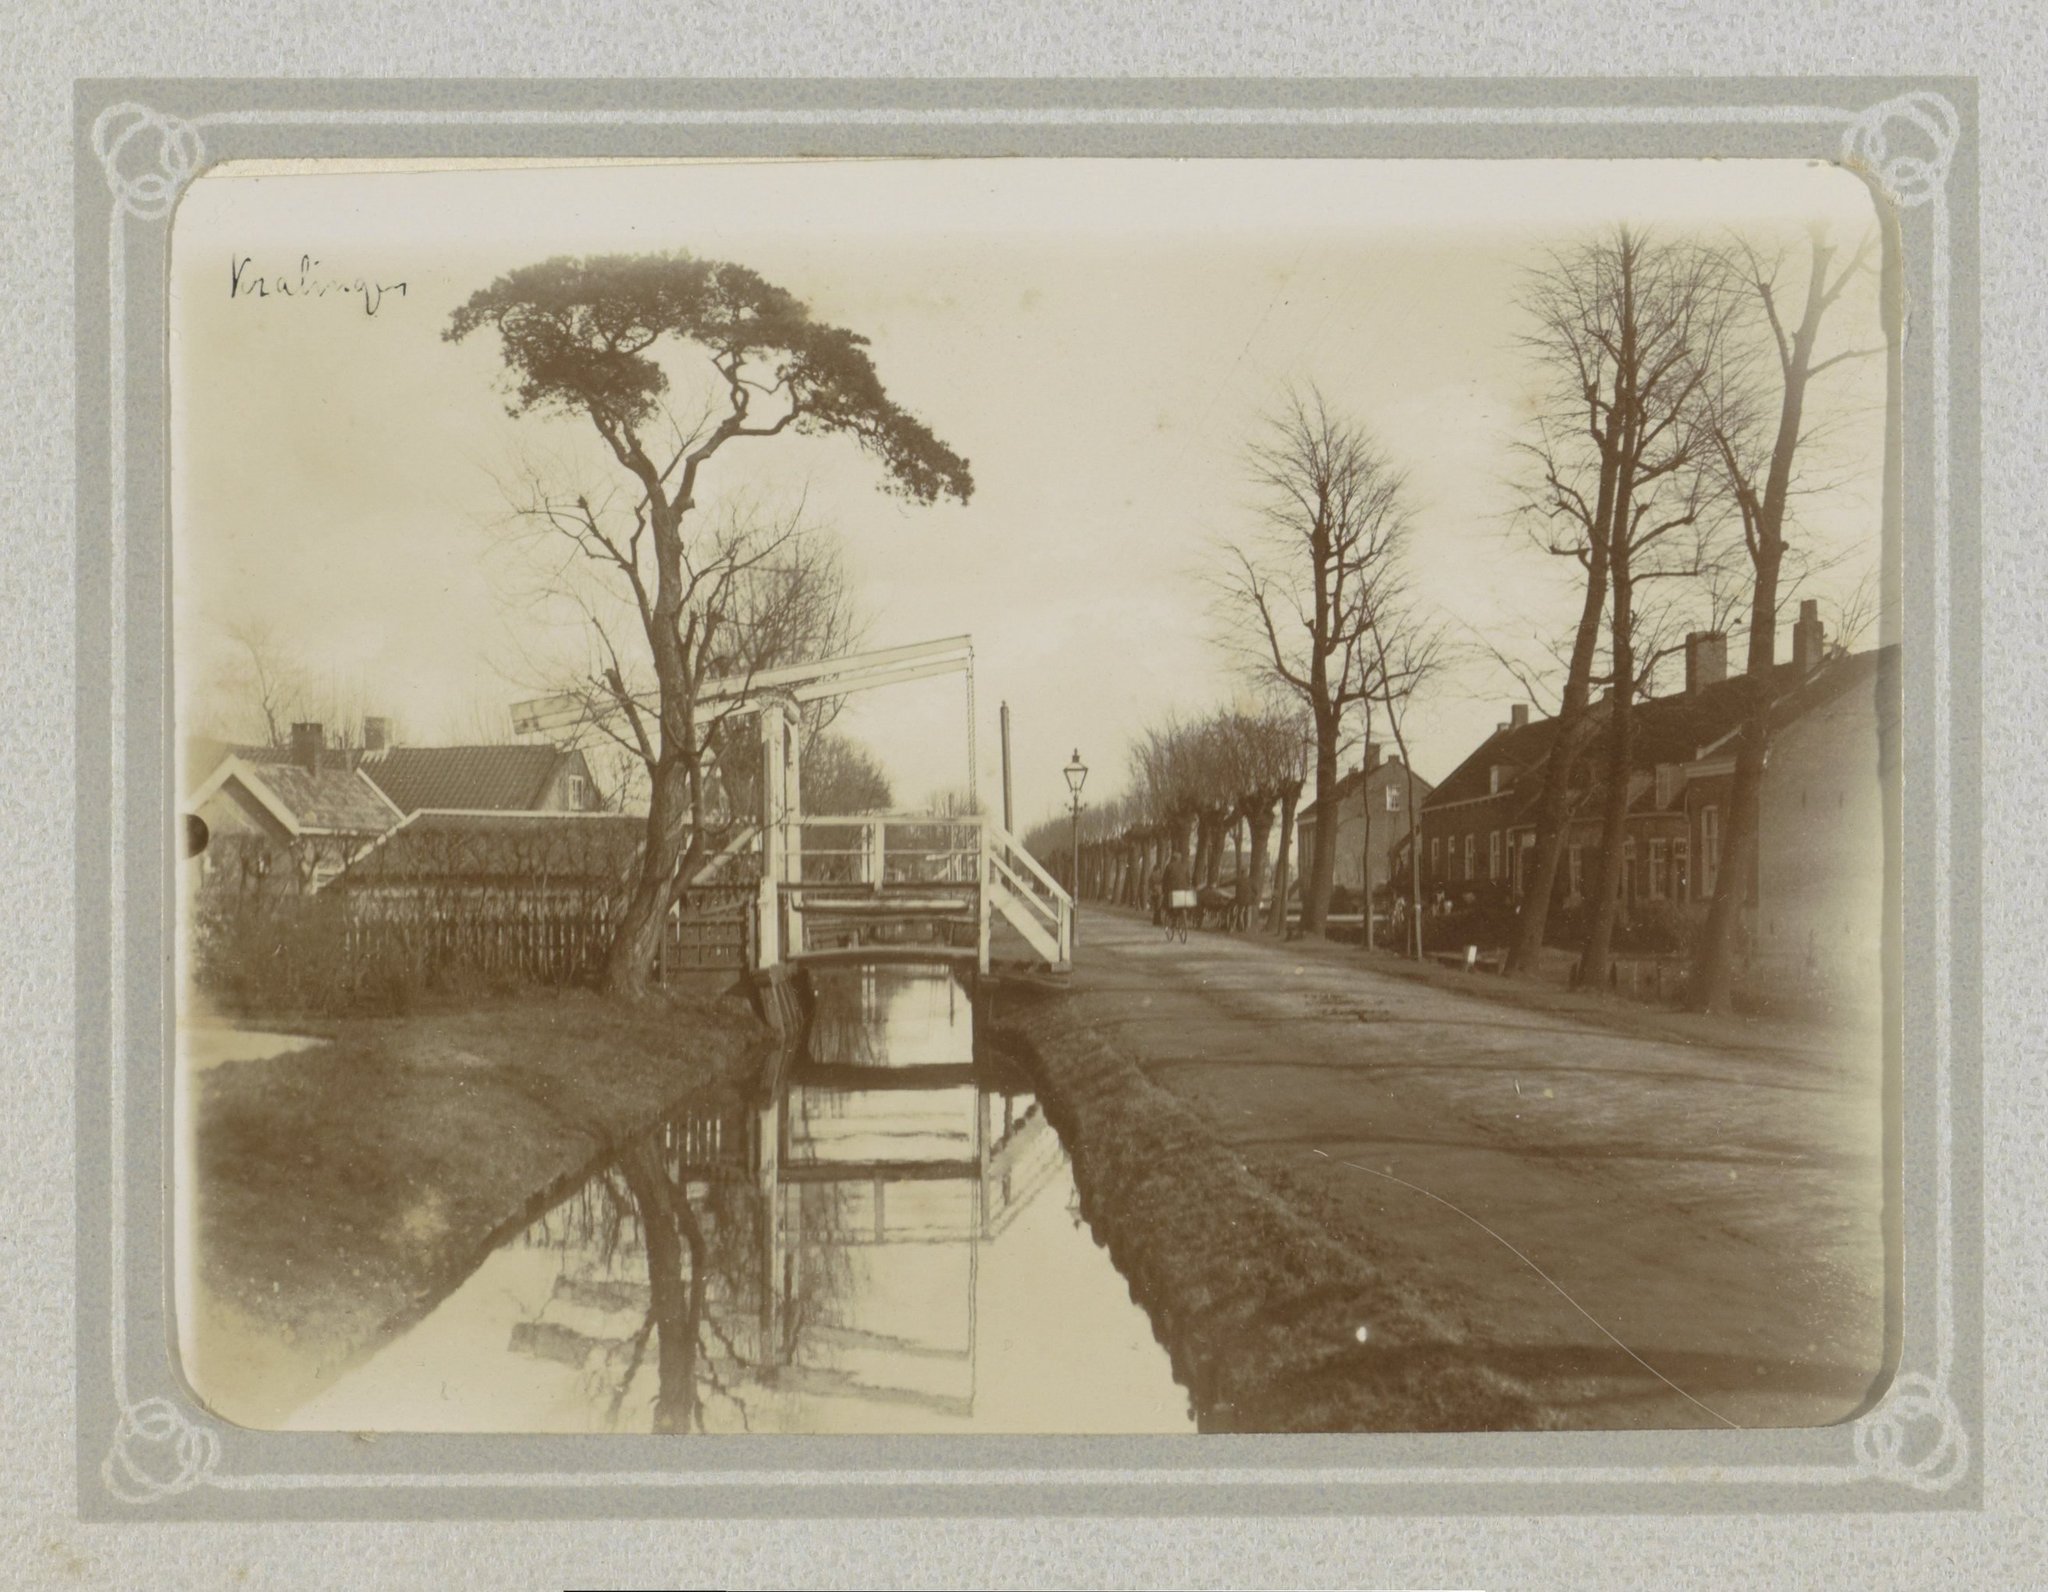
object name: photograph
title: Kralingen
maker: folkert idzes de jong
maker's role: architect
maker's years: 1877-1929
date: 1905-1907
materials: photographic support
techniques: gelatin silver print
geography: netherlands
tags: rural housing, e.g. country-house, villa, cottage, the usual house or row of houses, bridge, small canal, ditch, netherlands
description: Onderdeel van Topografisch album van Nederlandse dorpen en steden 1905.